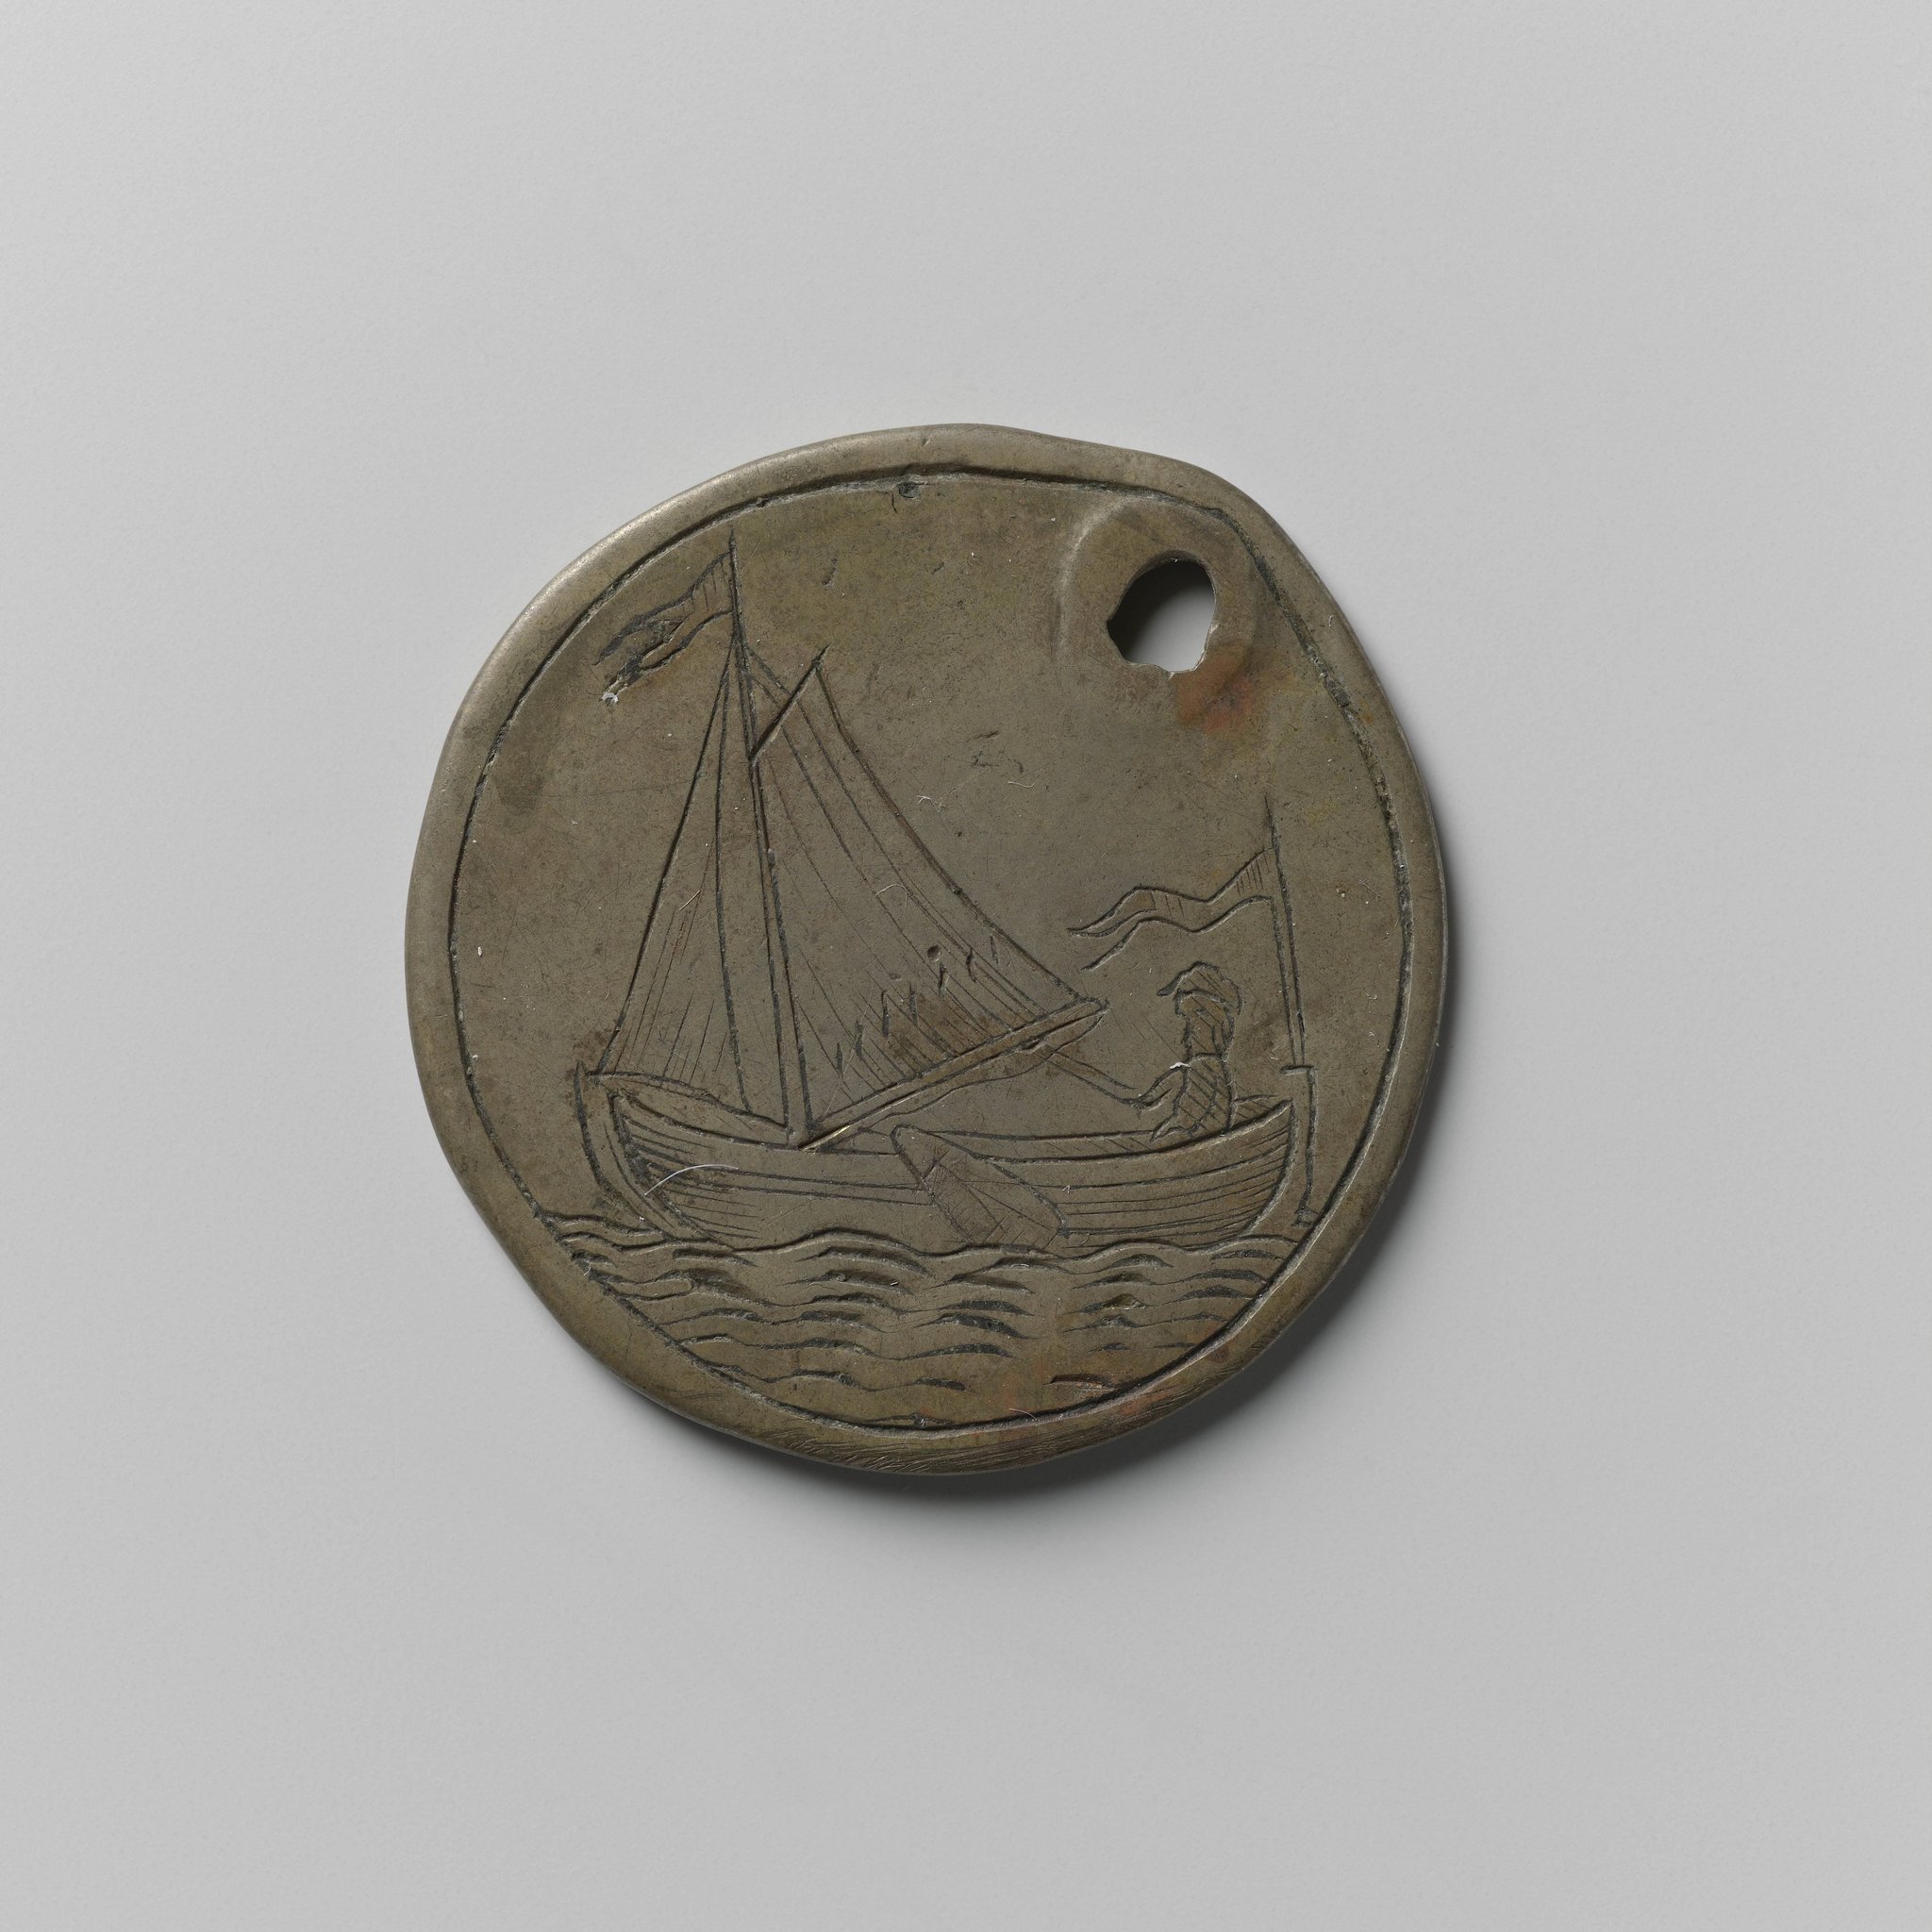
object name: medal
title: Roei-, steiger- en schuitenvoerdersgilde van Amsterdam, gildepenning van Dirck Klaasse, ligplaats Nieuwe Brug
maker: Anonymous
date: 1714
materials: metal alloy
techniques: engraving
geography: amsterdam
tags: amsterdam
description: Penning met gat erin. Voorzijde: naar links varende zeilboot; op achterplecht: zittende man en vlag. Keerzijde: opschrift monogram van letters D en K tussen letters N en B.